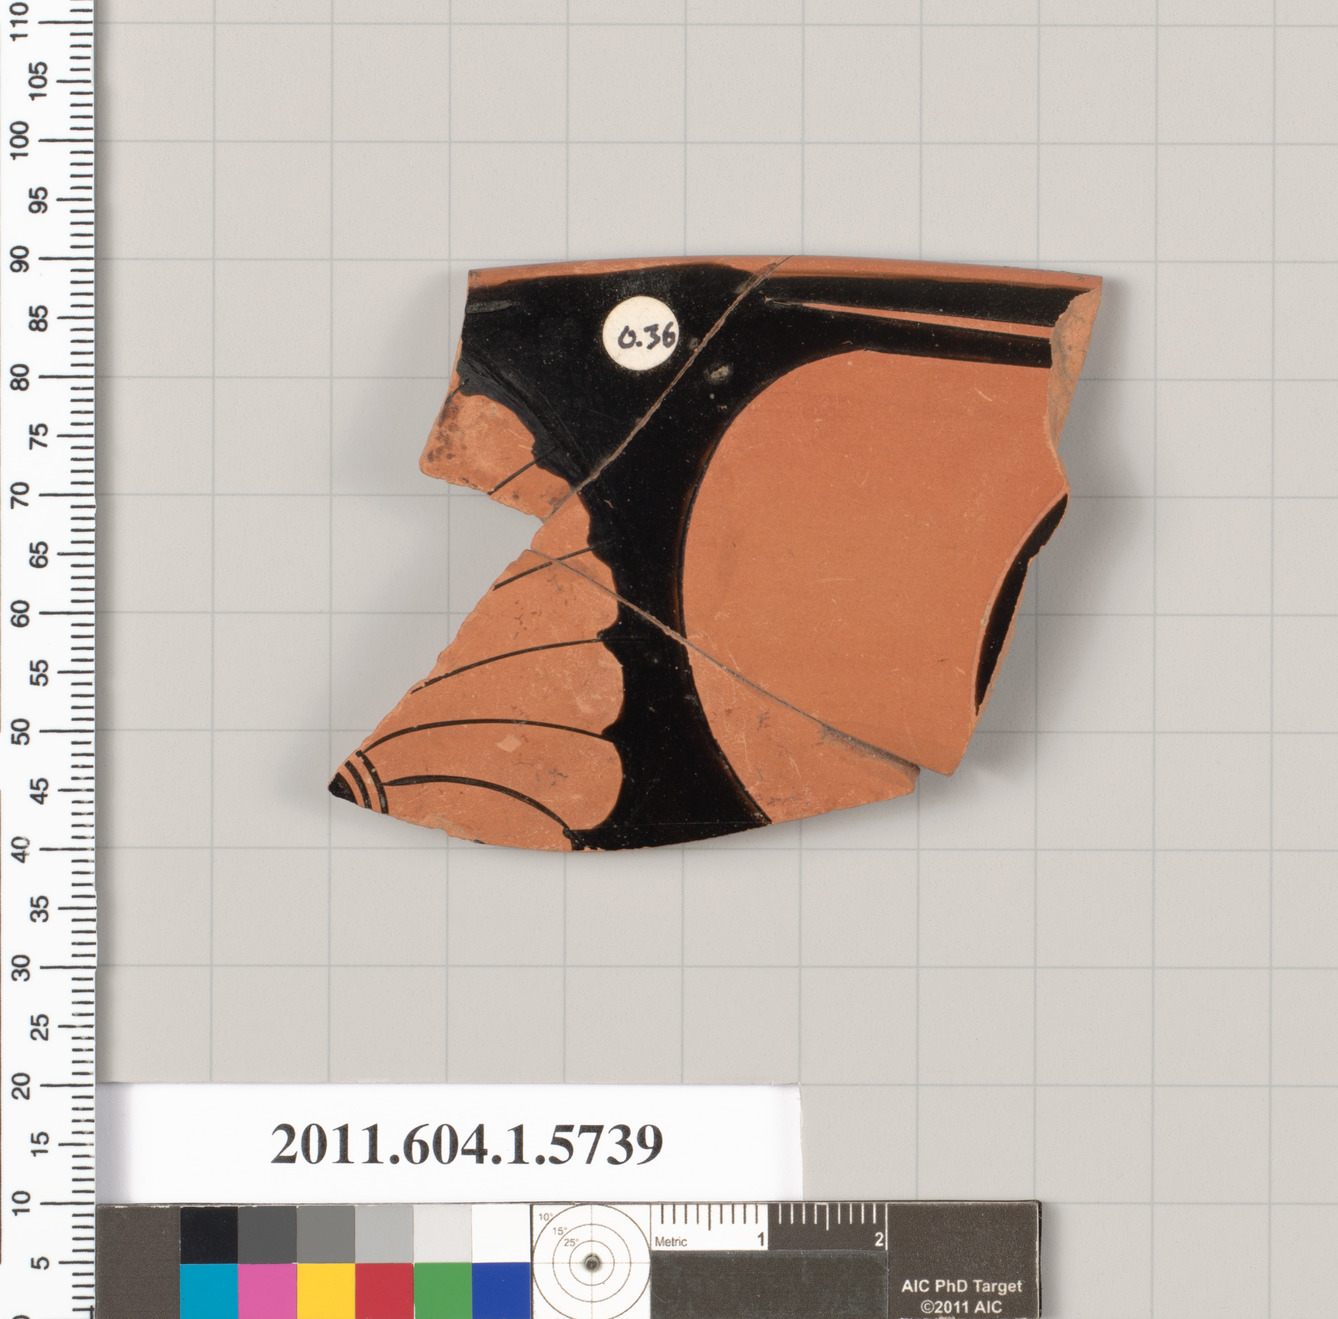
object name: kylix fragment, eye cup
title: Terracotta rim fragment of a kylix: eye-cup (drinking cup)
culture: greek, attic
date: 520-510 BCE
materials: terracotta